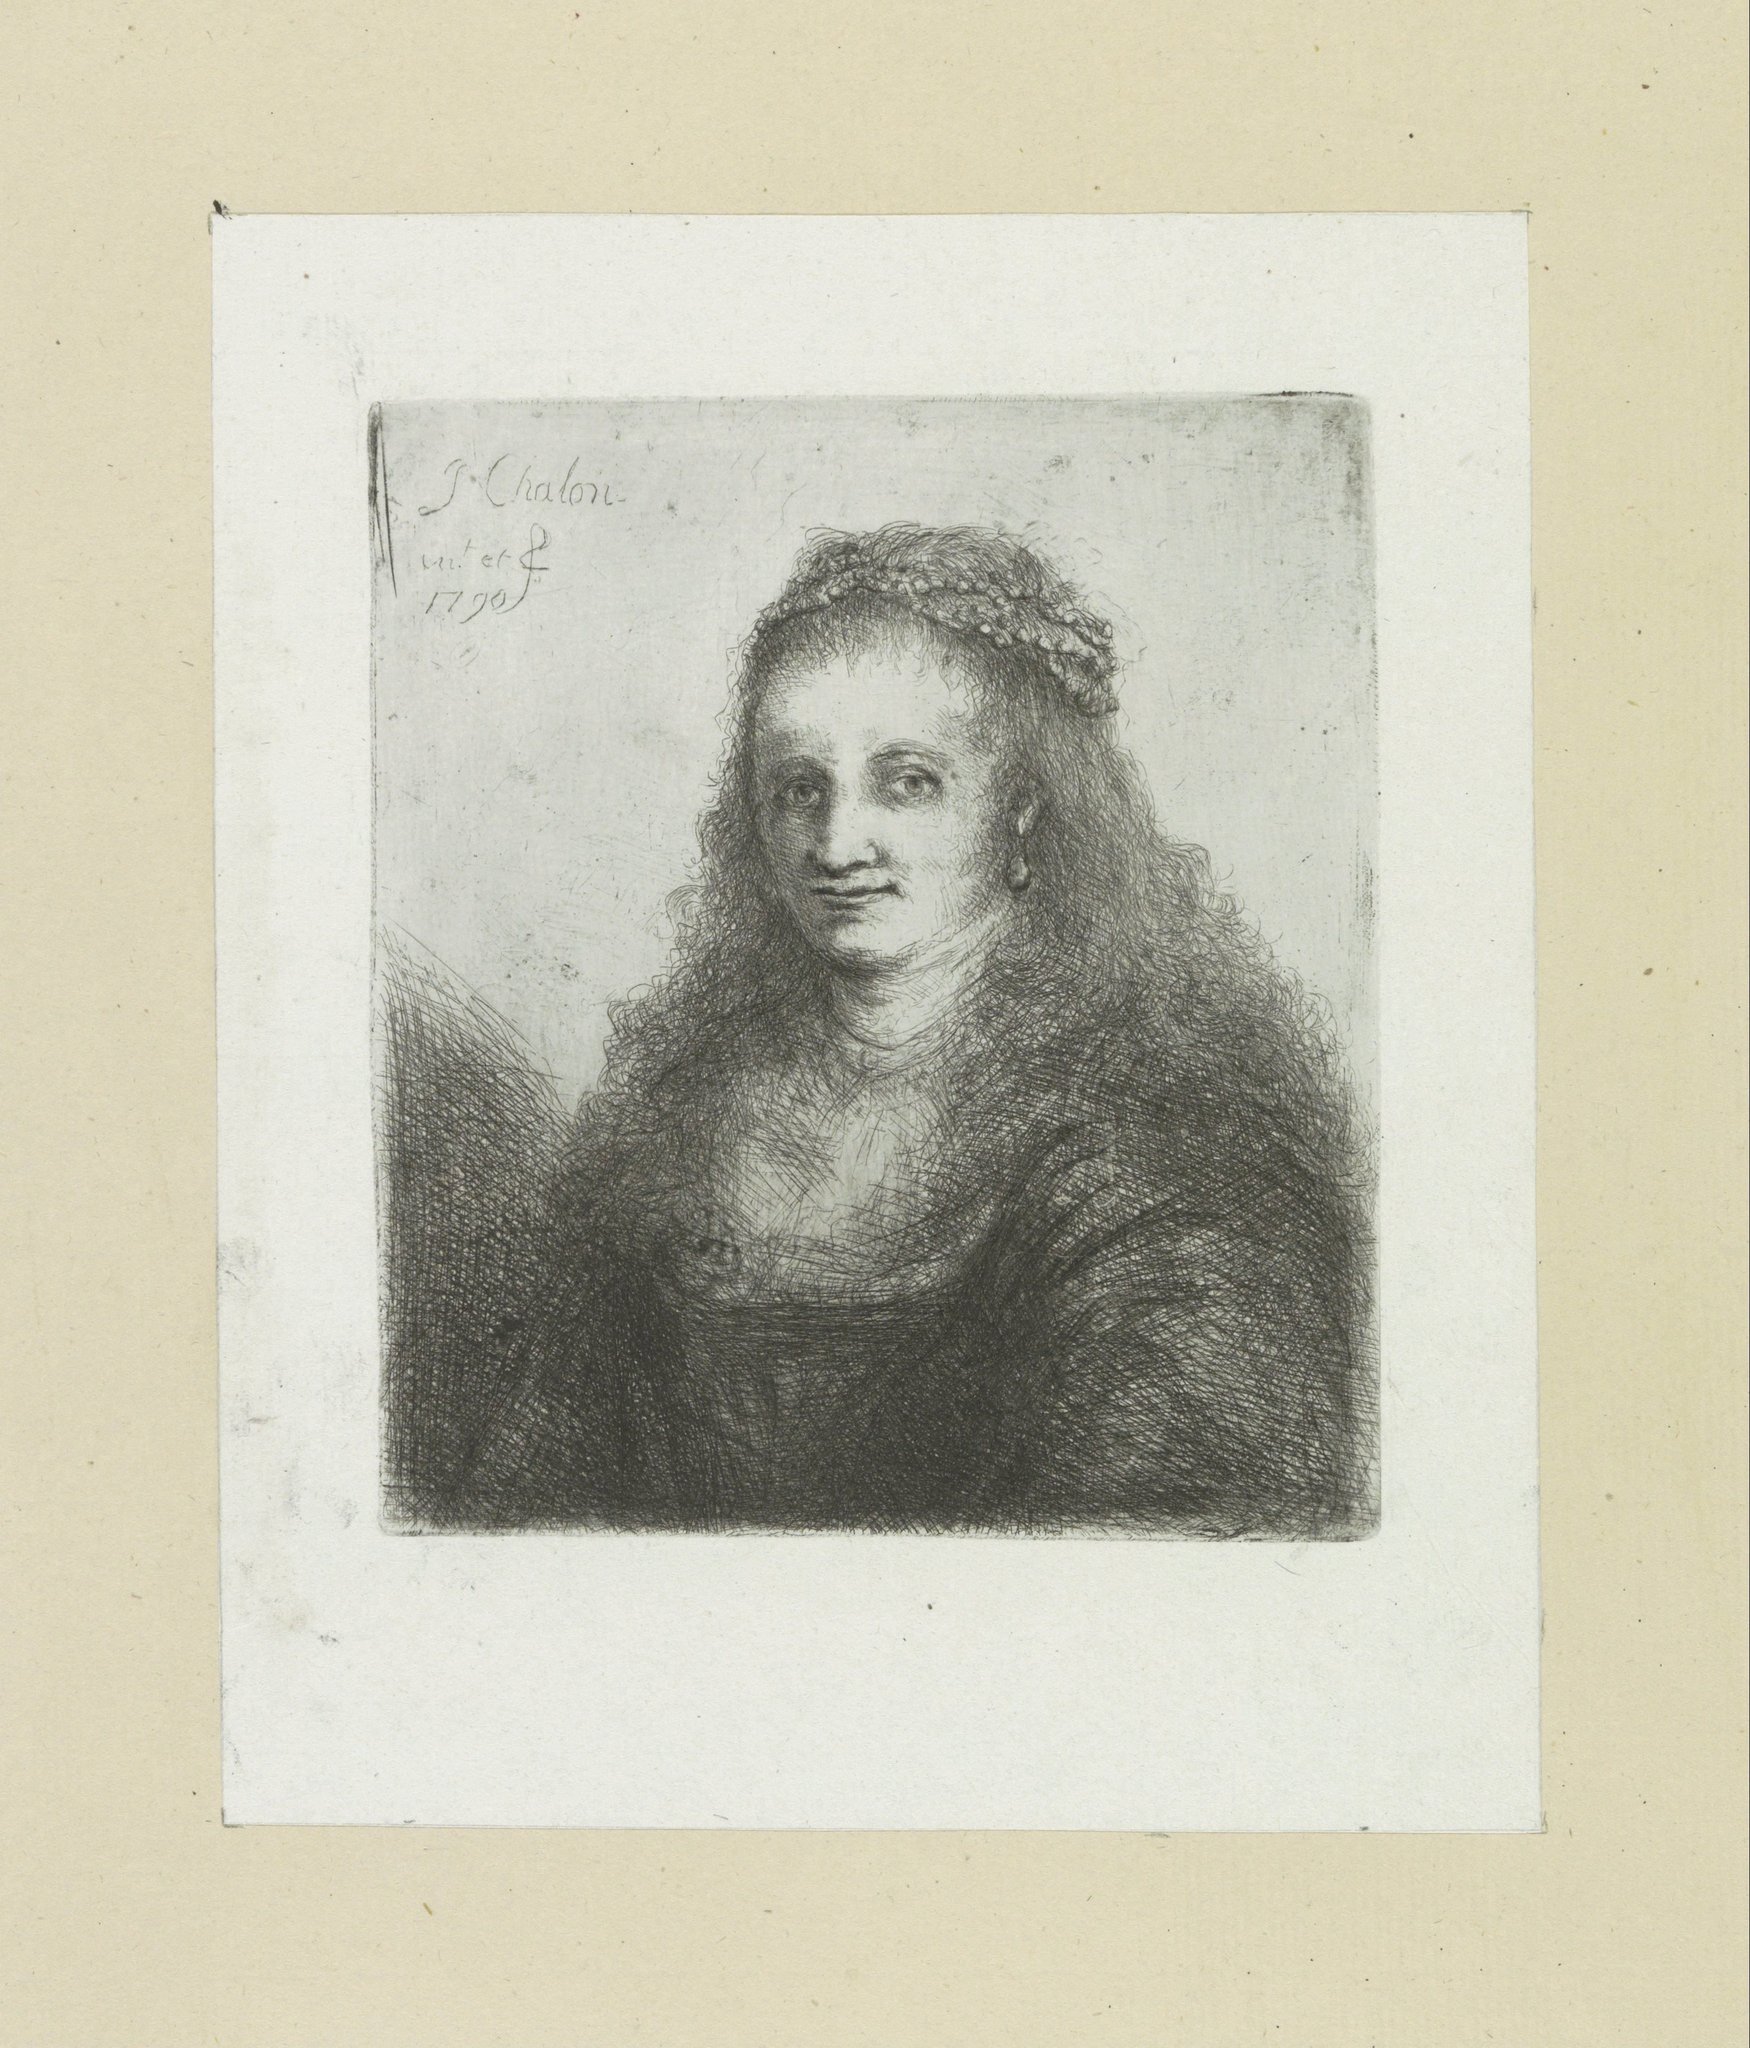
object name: print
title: Vrouw met een parelsnoer in het haar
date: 1790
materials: paper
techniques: drypoint, etching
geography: london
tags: head-gear, pearl; pearl necklace, morphology of human expression (+ adult female (human being))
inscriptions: collector's mark: ‘B’, collector's mark: ‘RIJKS / MUSM’